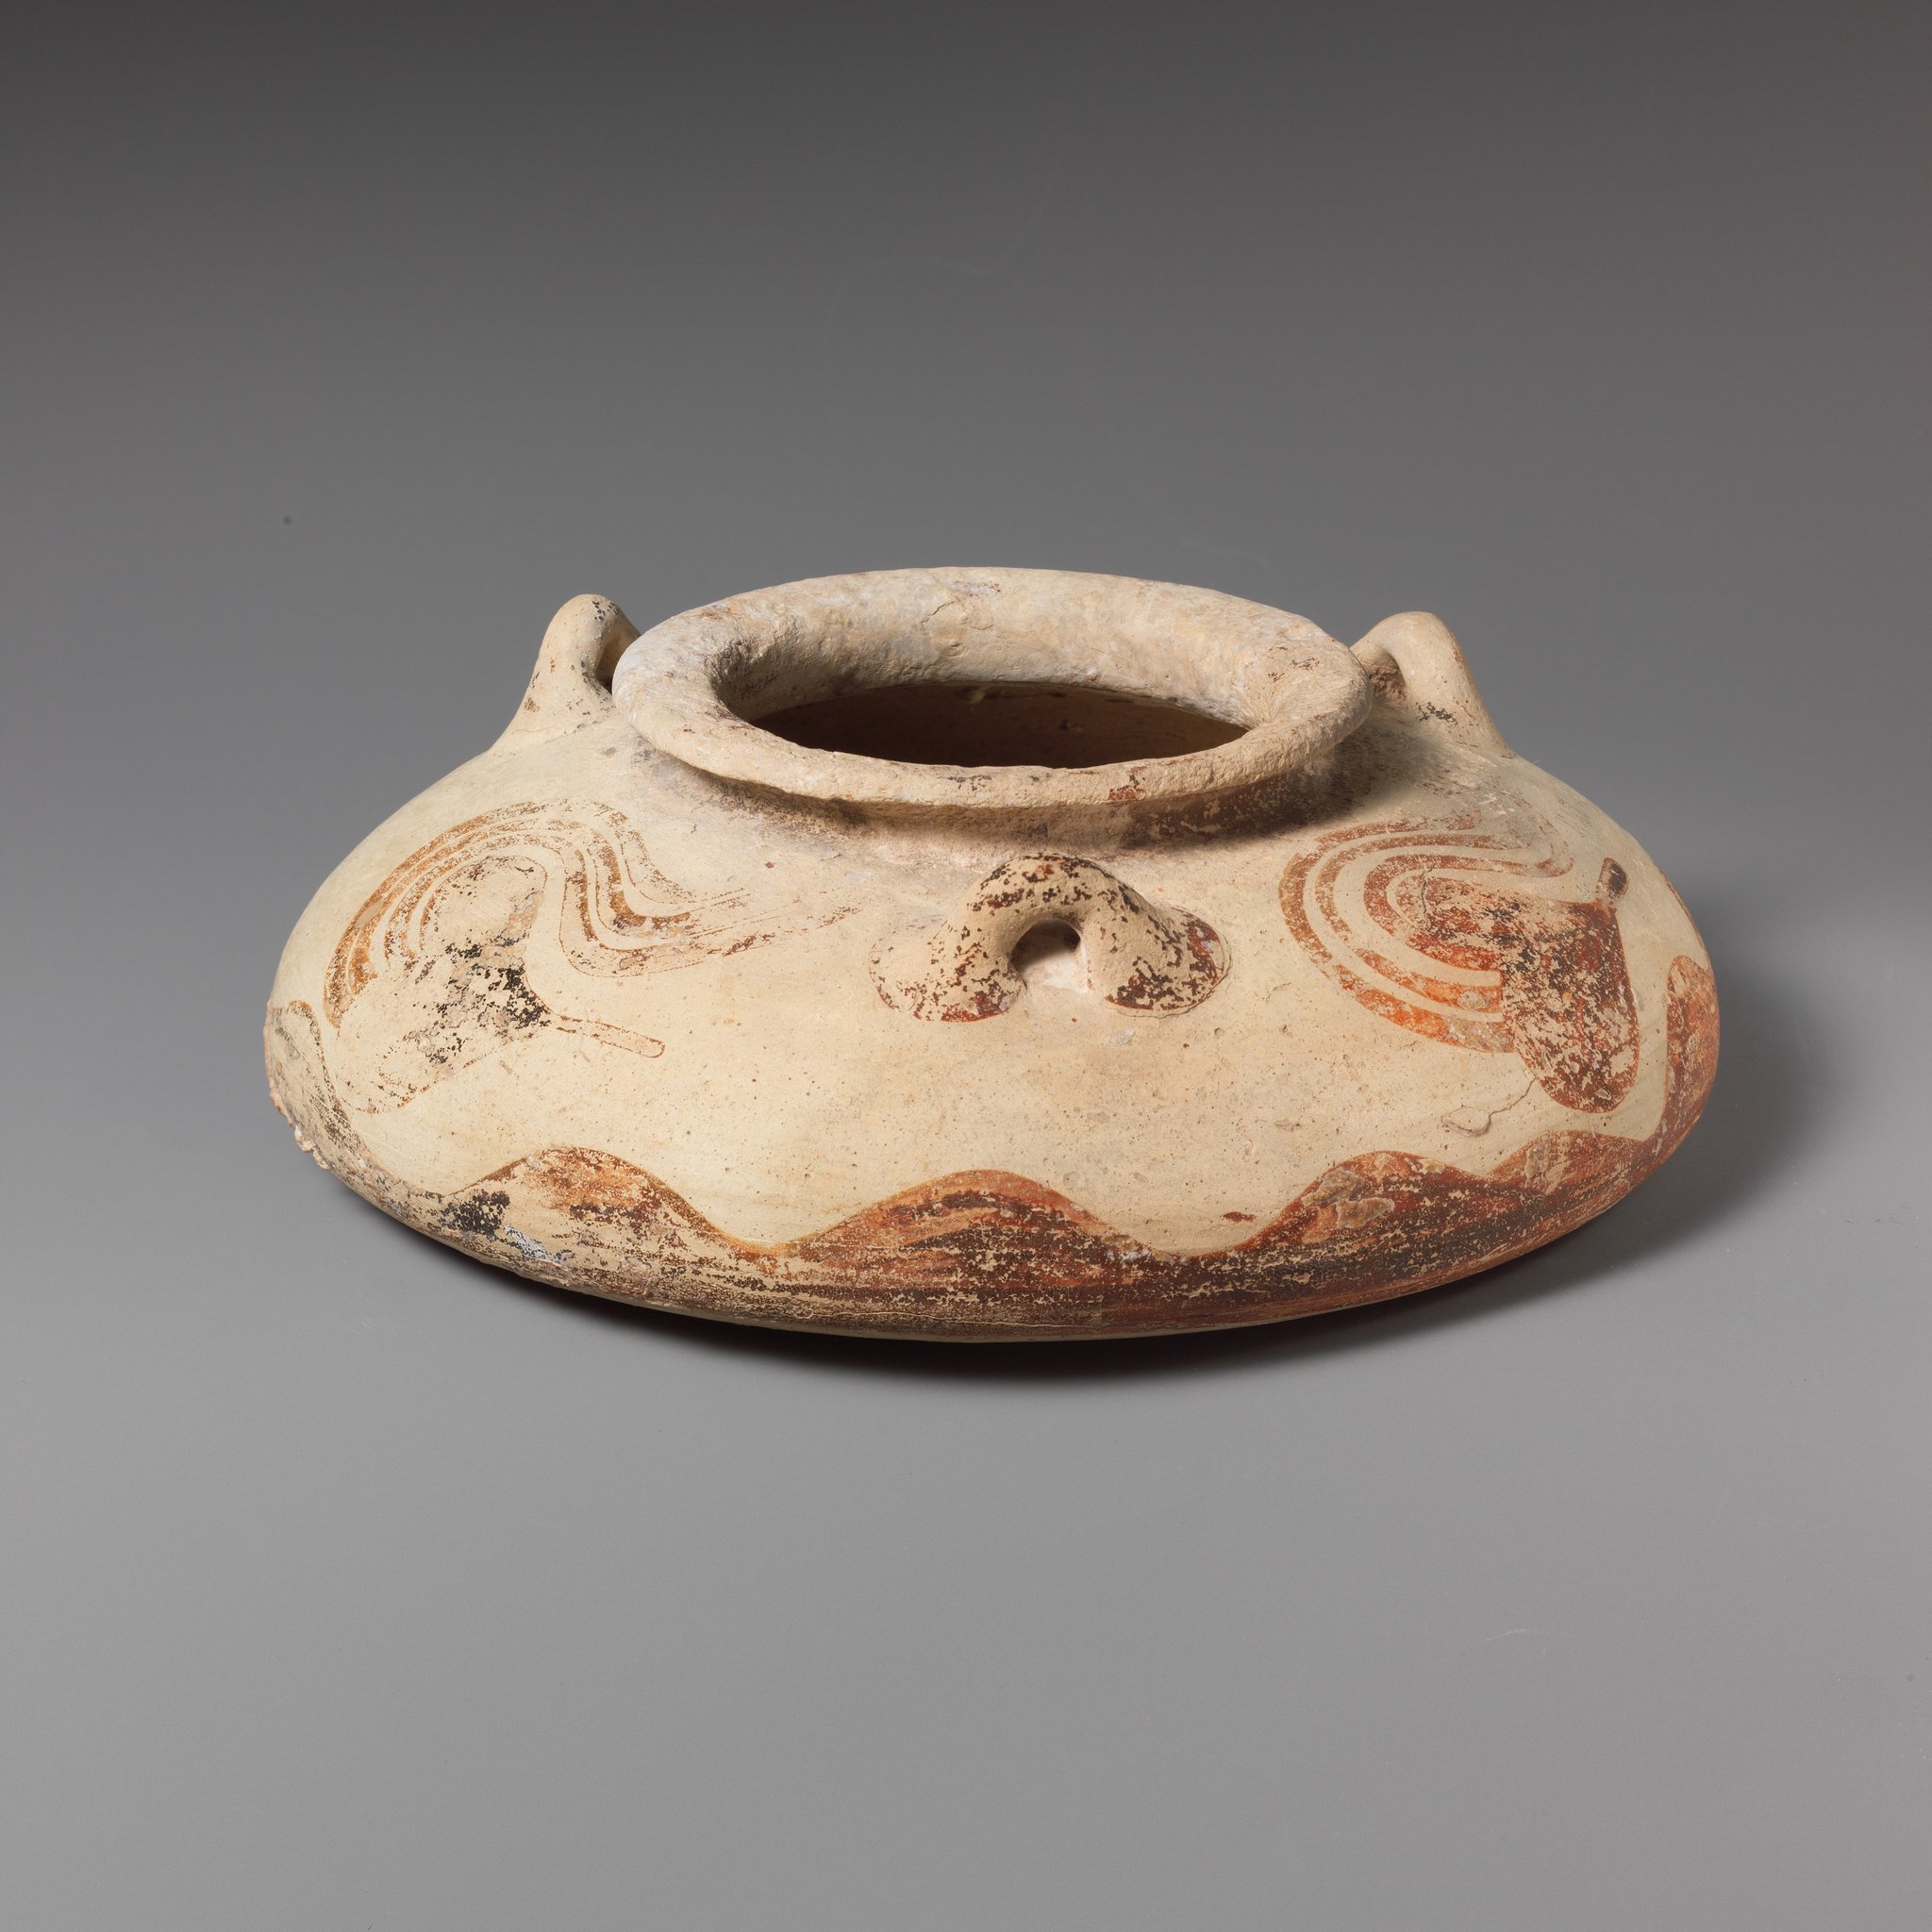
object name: jar, squat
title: Terracotta squat alabastron (jar)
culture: mycenaean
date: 1300-1201 BCE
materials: terracotta